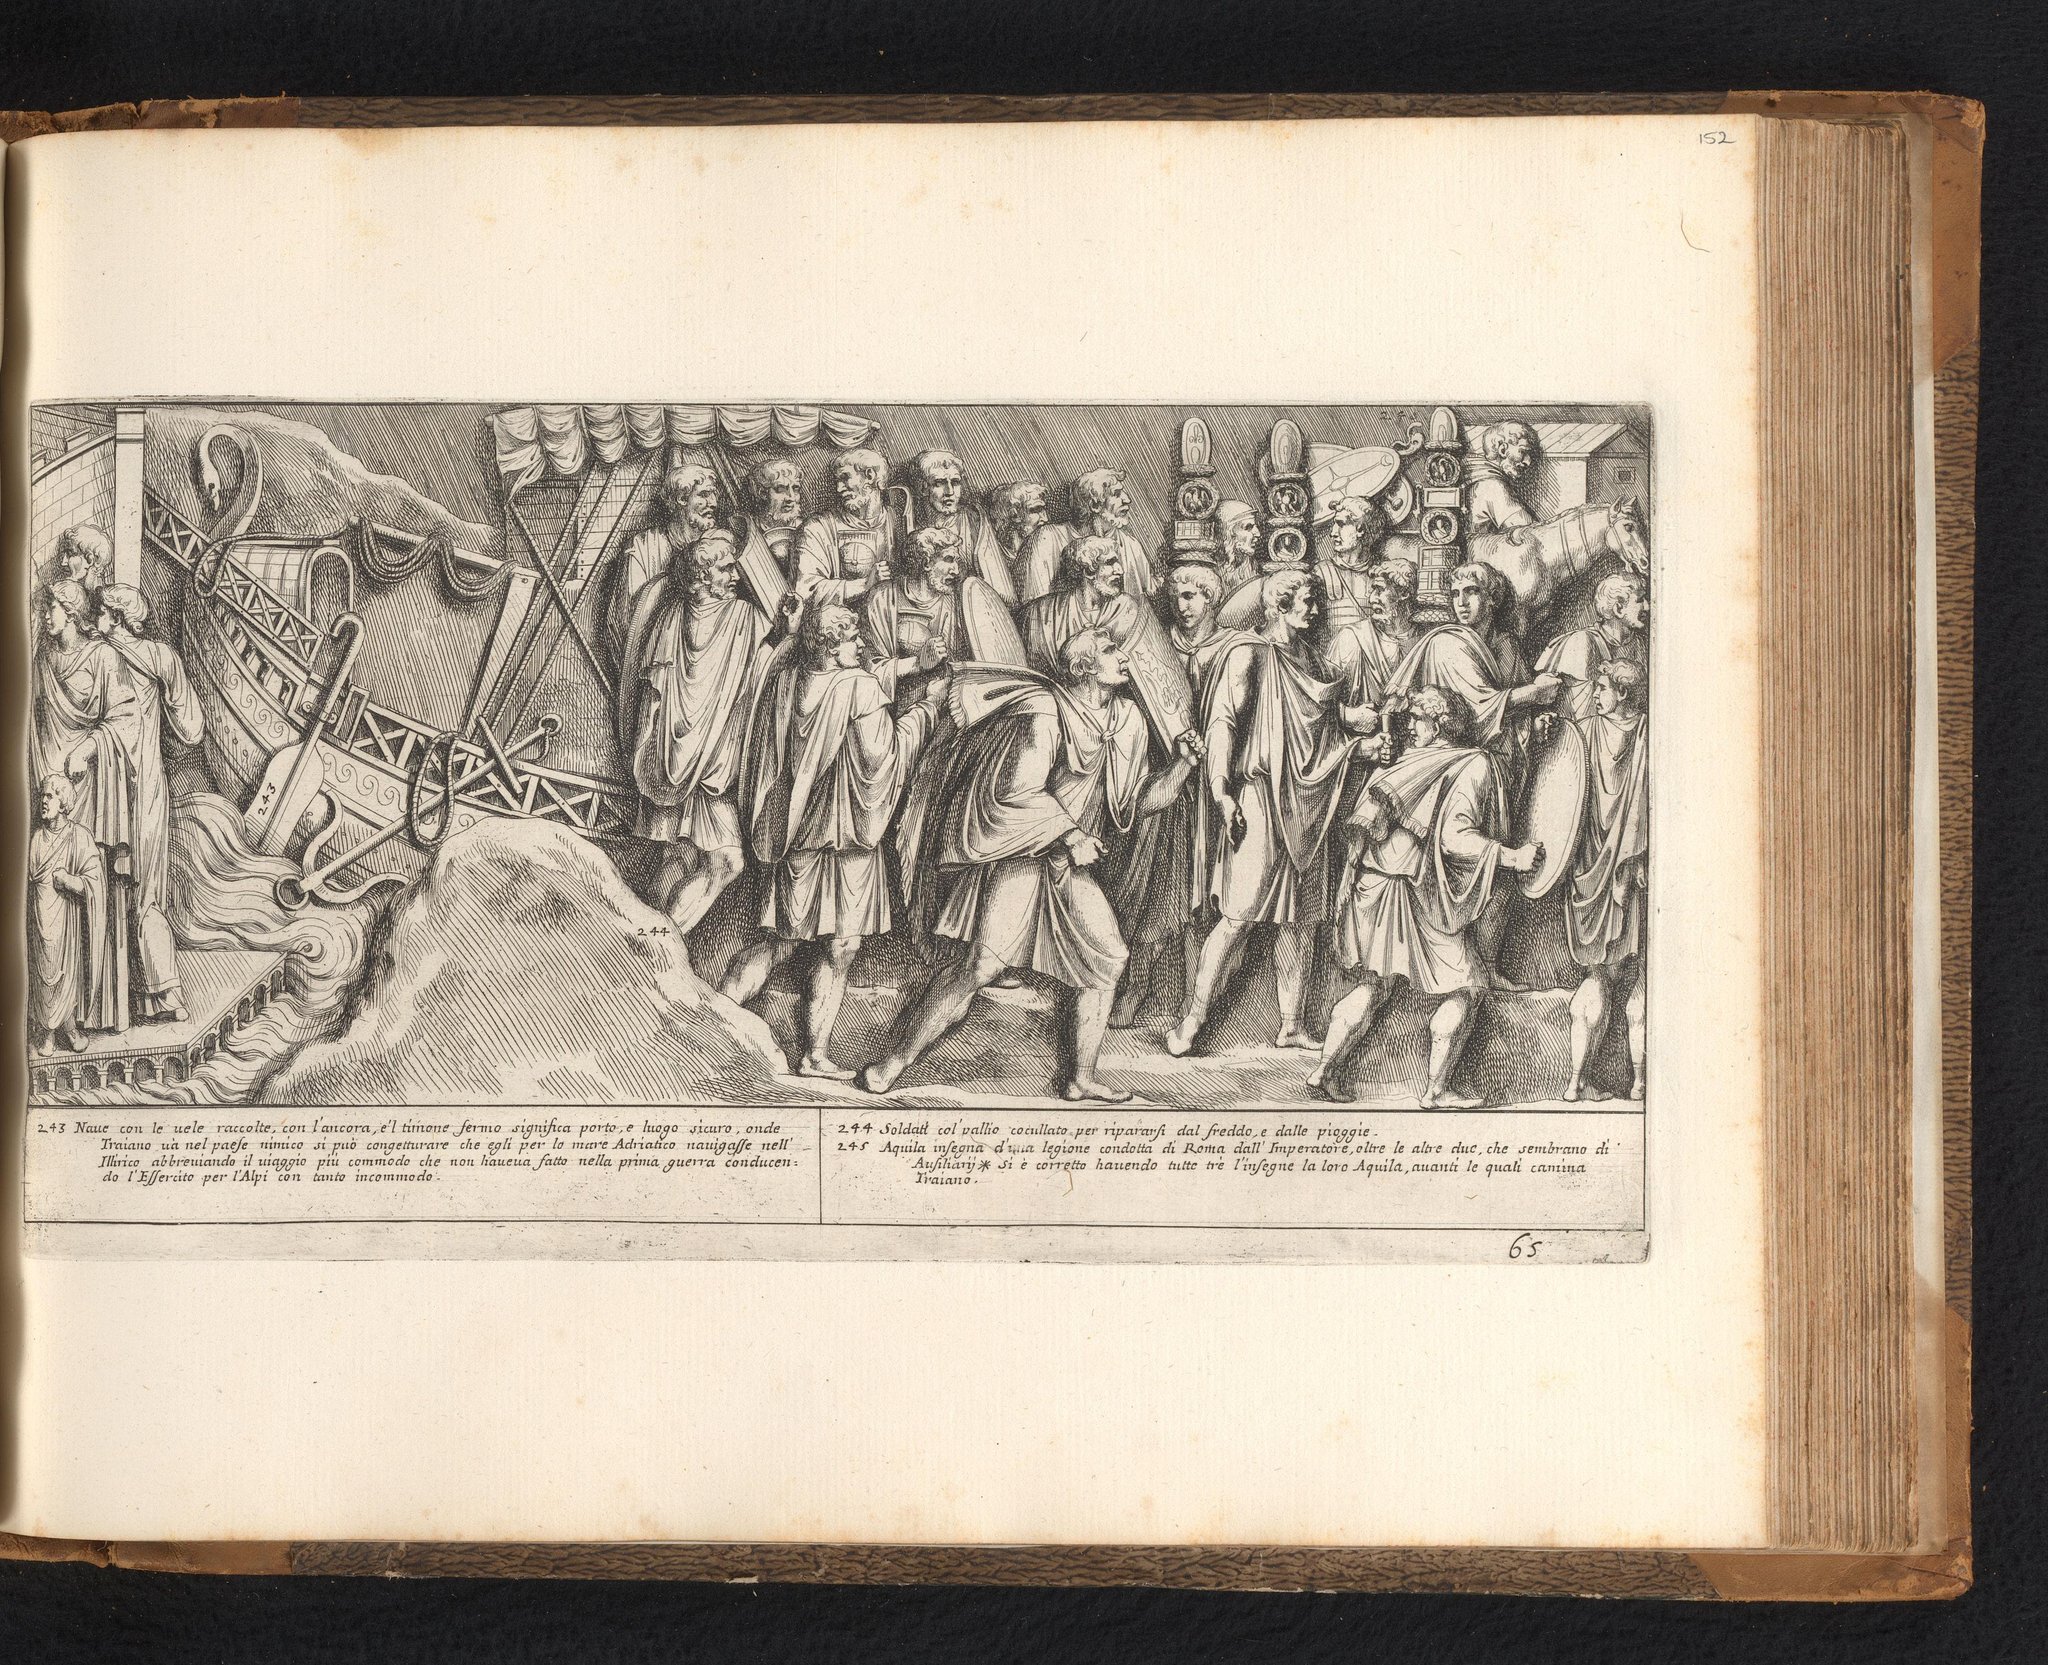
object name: album leaf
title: Colonna Traiana eretta dal senato, e popolo Romano all' imperatore Traiano Augusto nel suo foro in Rom (...)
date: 1637-1691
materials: paper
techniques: etching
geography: rome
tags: triumphal column with helical friezes, piece of sculpture, reproduction of a piece of sculpture, the soldier; the soldier's life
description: Detail van het spiraalvormige gebeeldhouwde fries op de Zuil van Trajanus. Het fries toont de oorlogen tussen de Romeinen en de Daciërs. Verklarende nummers in de ondermarge. Prent maakt deel uit van een album.